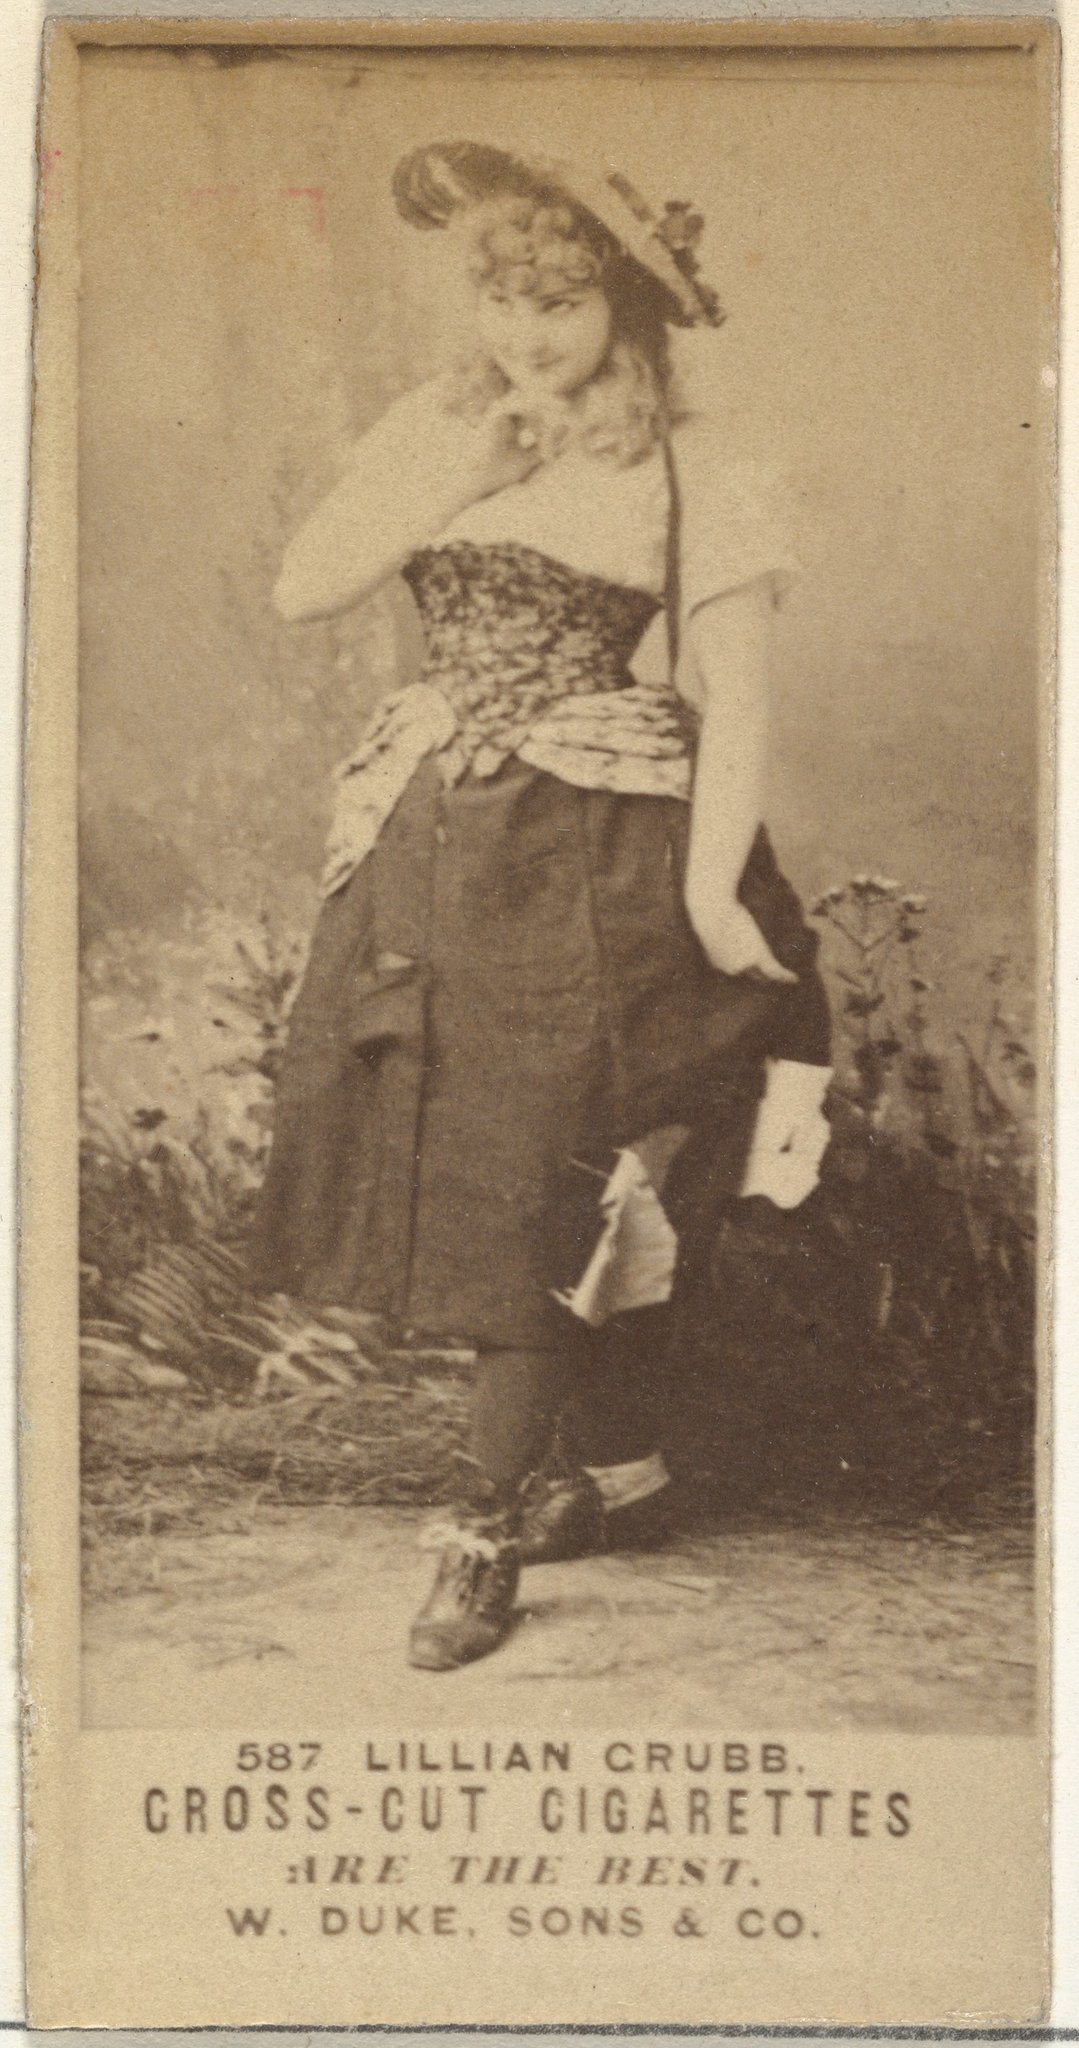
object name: photograph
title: Card Number 587, Lillian Grubb, from the Actors and Actresses series (N145-3) issued by Duke Sons & Co. to promote Cross Cut Cigarettes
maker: w. duke, sons & co.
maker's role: publisher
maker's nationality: american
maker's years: 1870-1920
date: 1880-1889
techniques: albumen silver print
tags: portraits,women,actresses